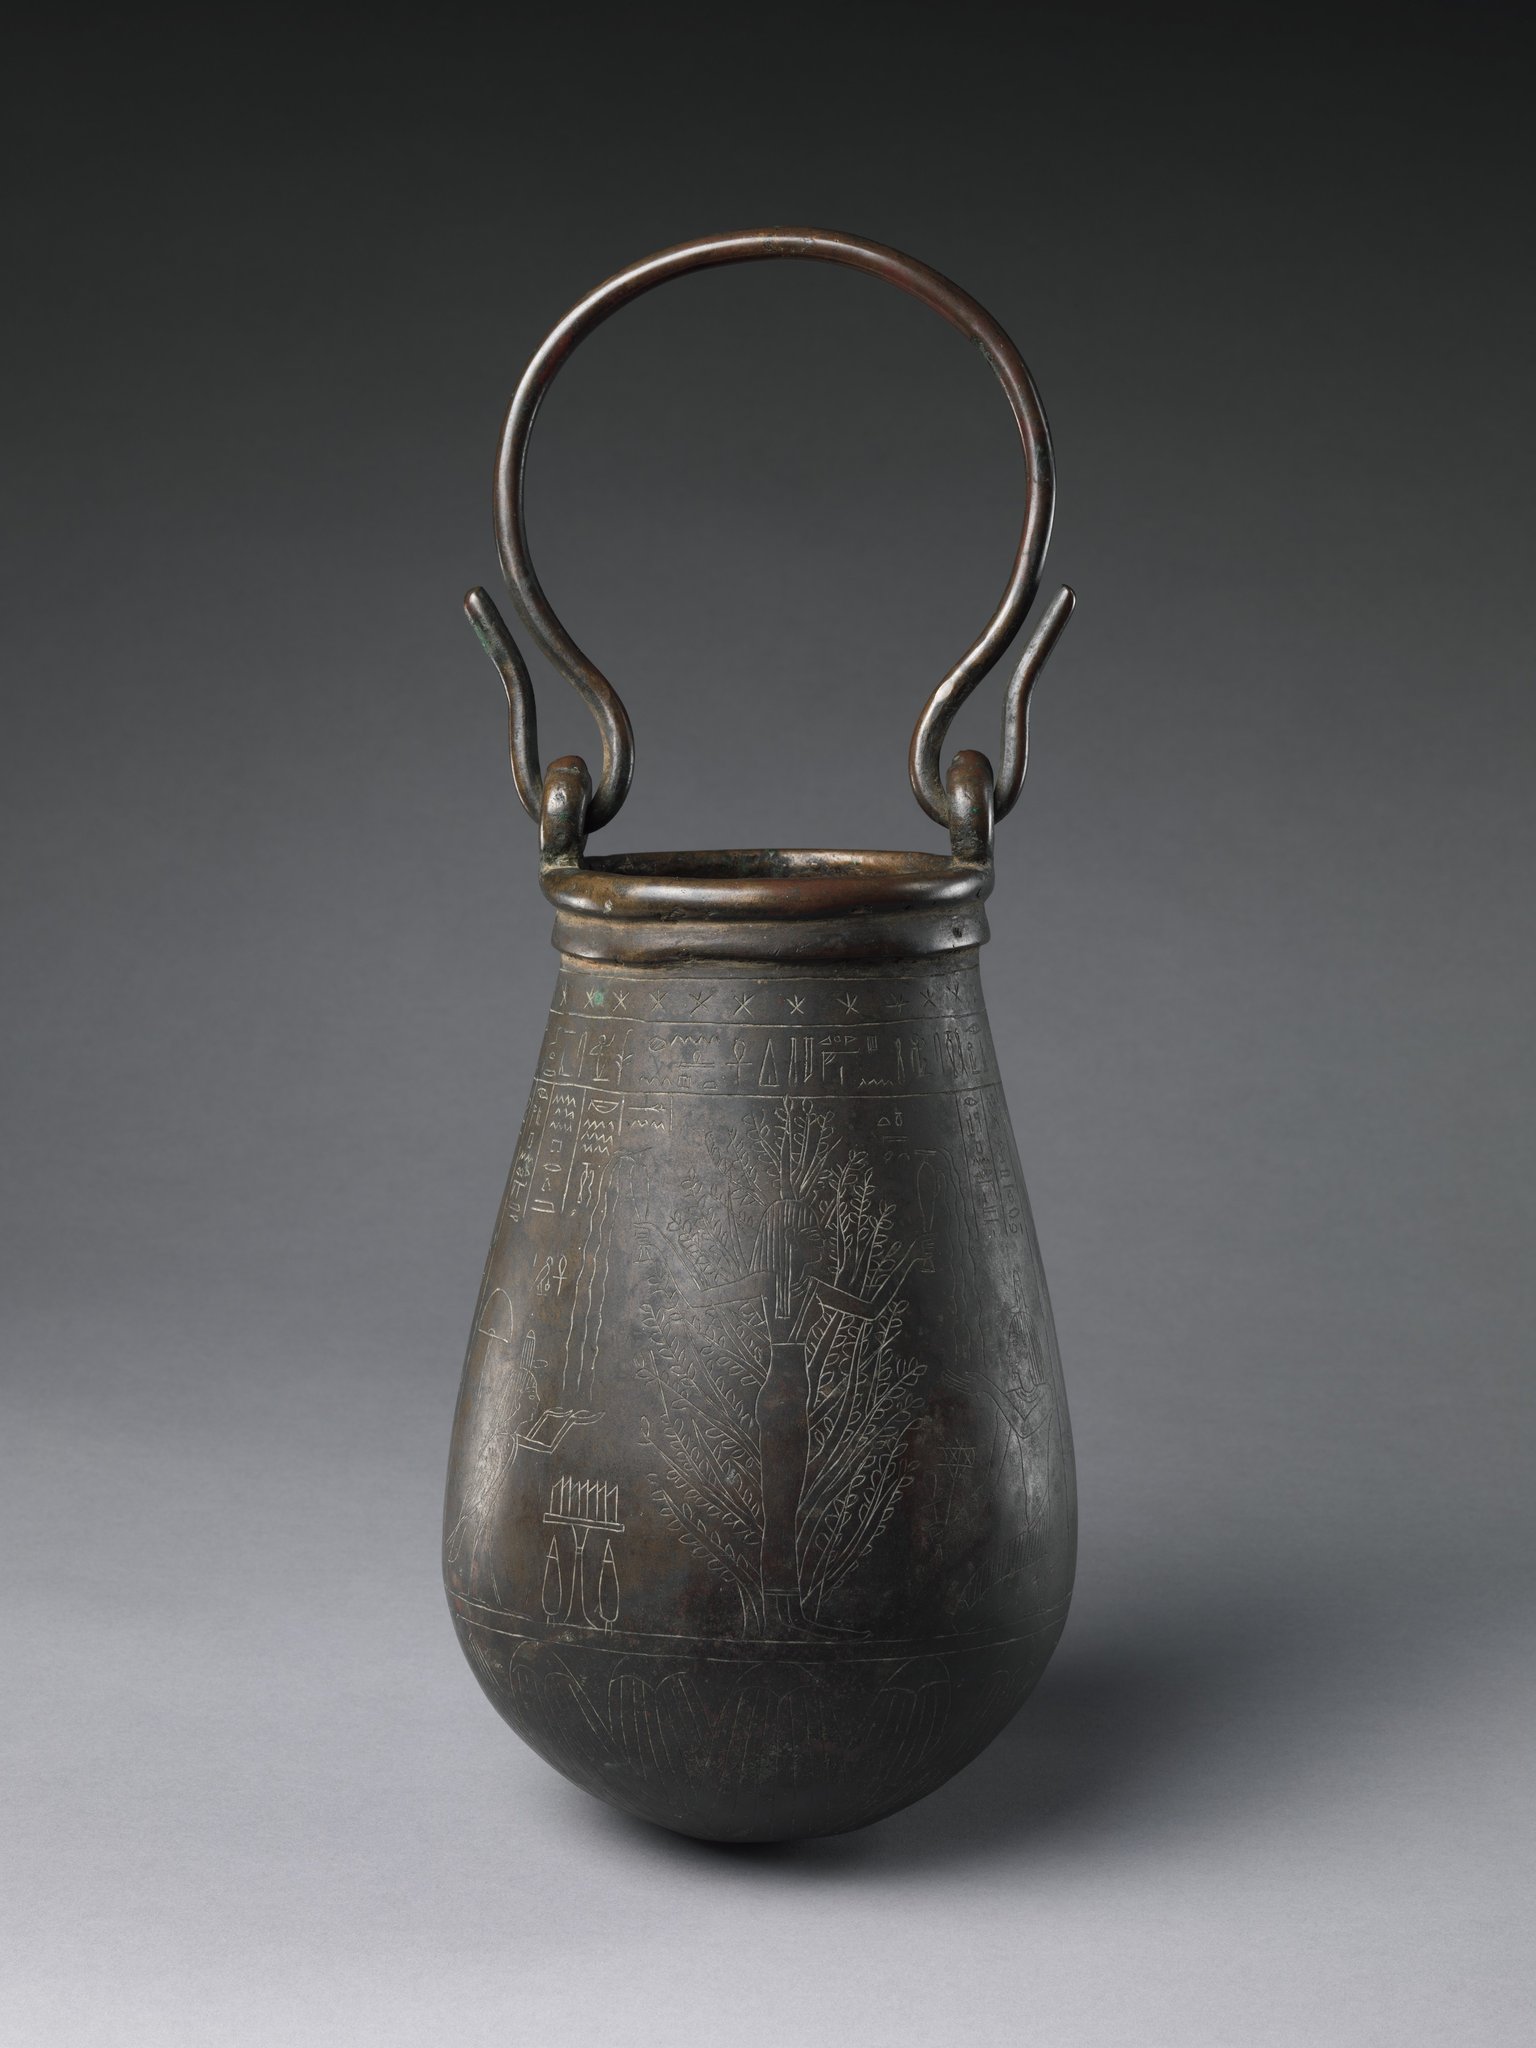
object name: situla, penmin, tree goddess, osiris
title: Ceremonial Situla of the 'Great Praised' Penmin showing Nut as a tree-goddess, and Osiris, Isis, Nephthys, and Harsiese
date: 332-330 BCE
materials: bronze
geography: egypt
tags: hieroglyphs